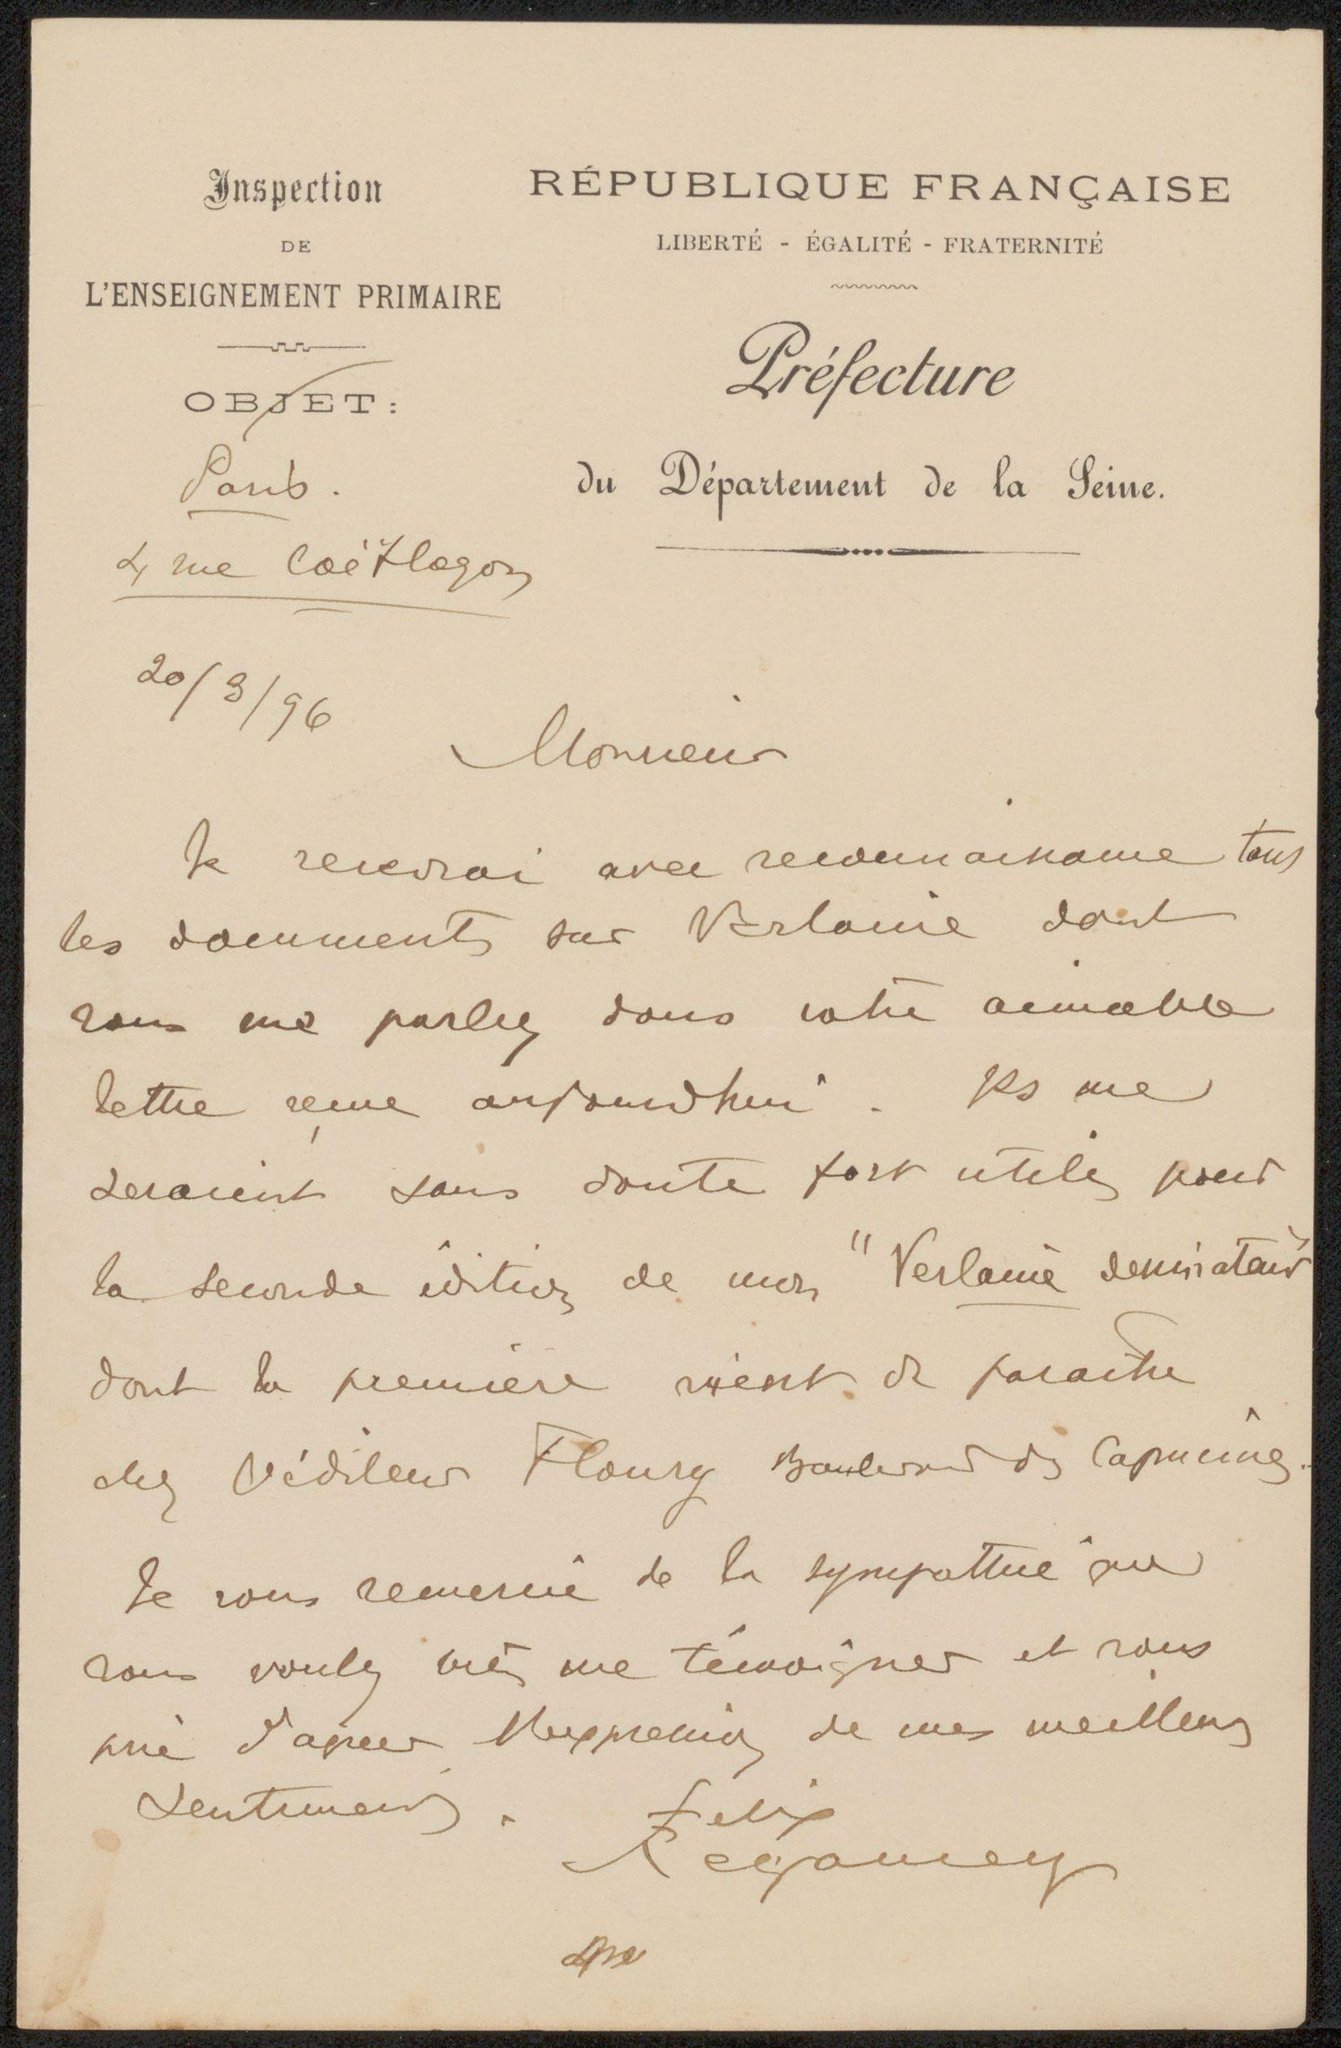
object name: letter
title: Brief aan Philip Zilcken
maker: félix régamey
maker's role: draughtsman, painter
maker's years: 1844-1907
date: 1896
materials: ink, paper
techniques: pen, printing, writing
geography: paris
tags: paul verlaine, publisher, henri floury, the hague, painter, draughtsman, philip zilcken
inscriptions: collector's mark: ‘RPK’